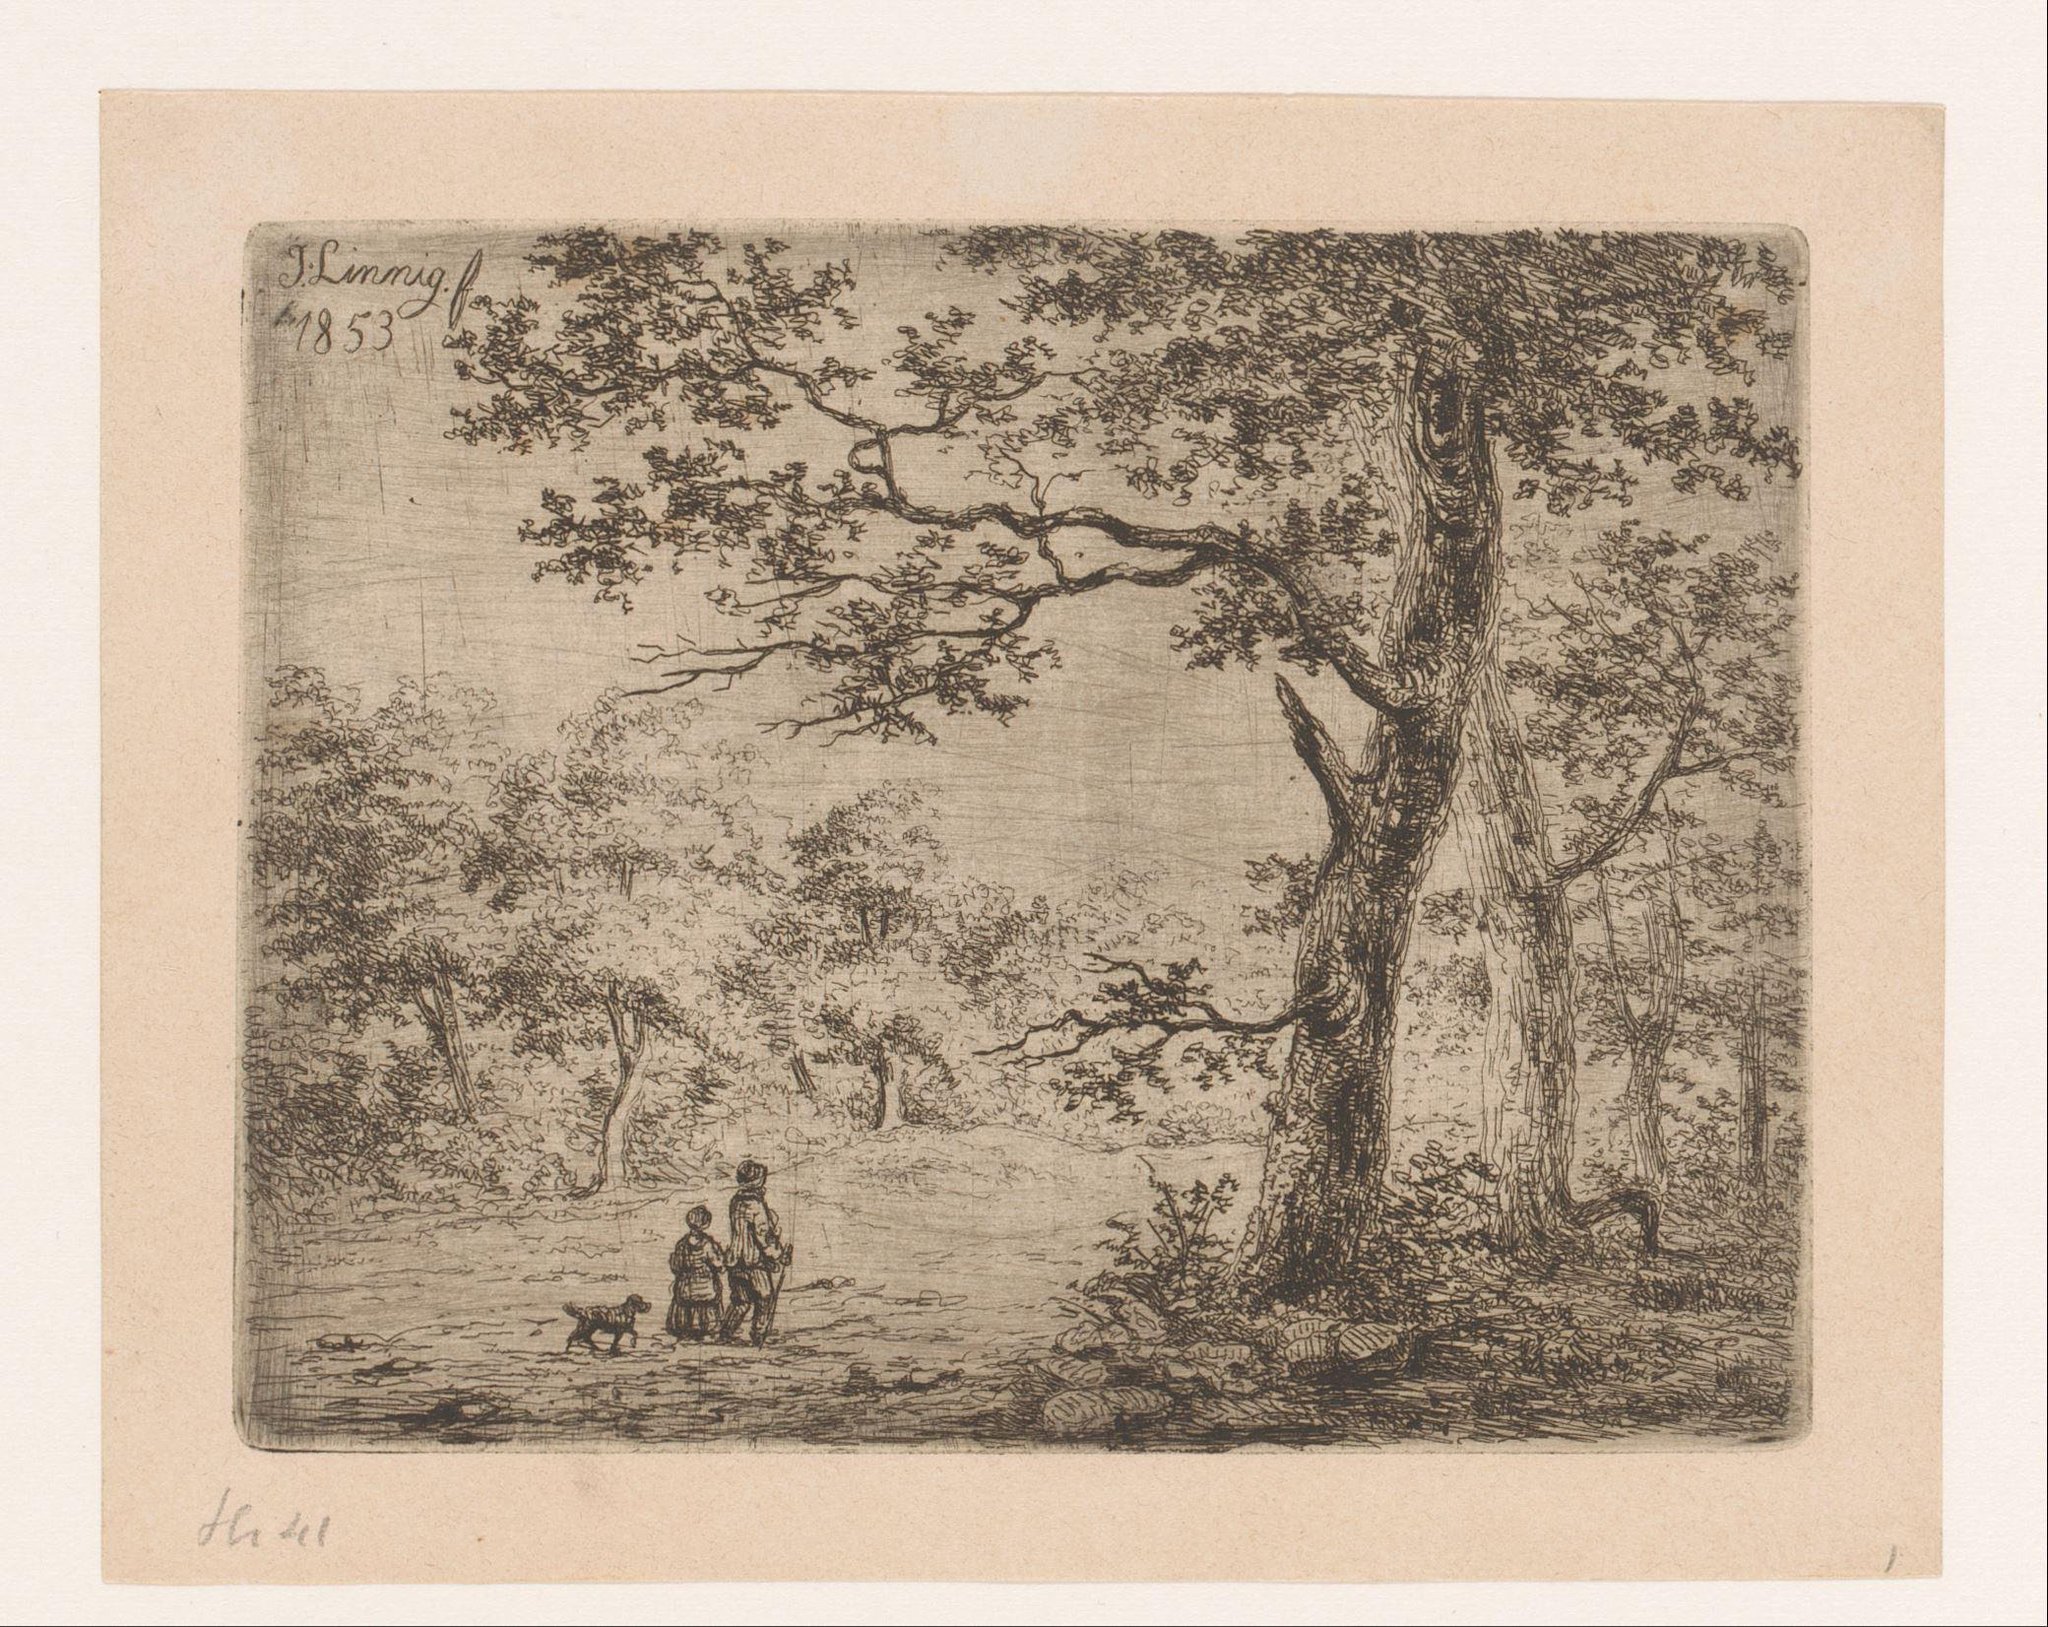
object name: print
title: Twee wandelaars met een hond in het bos bij Schoten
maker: jean théodore joseph linnig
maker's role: draughtsman, print maker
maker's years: 1815-1891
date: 1853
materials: paper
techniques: etching, intaglio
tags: forest path or lane (+ landscape with figures, staffage)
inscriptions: collector's mark: Lugt 1485, collector's mark: Lugt 2228